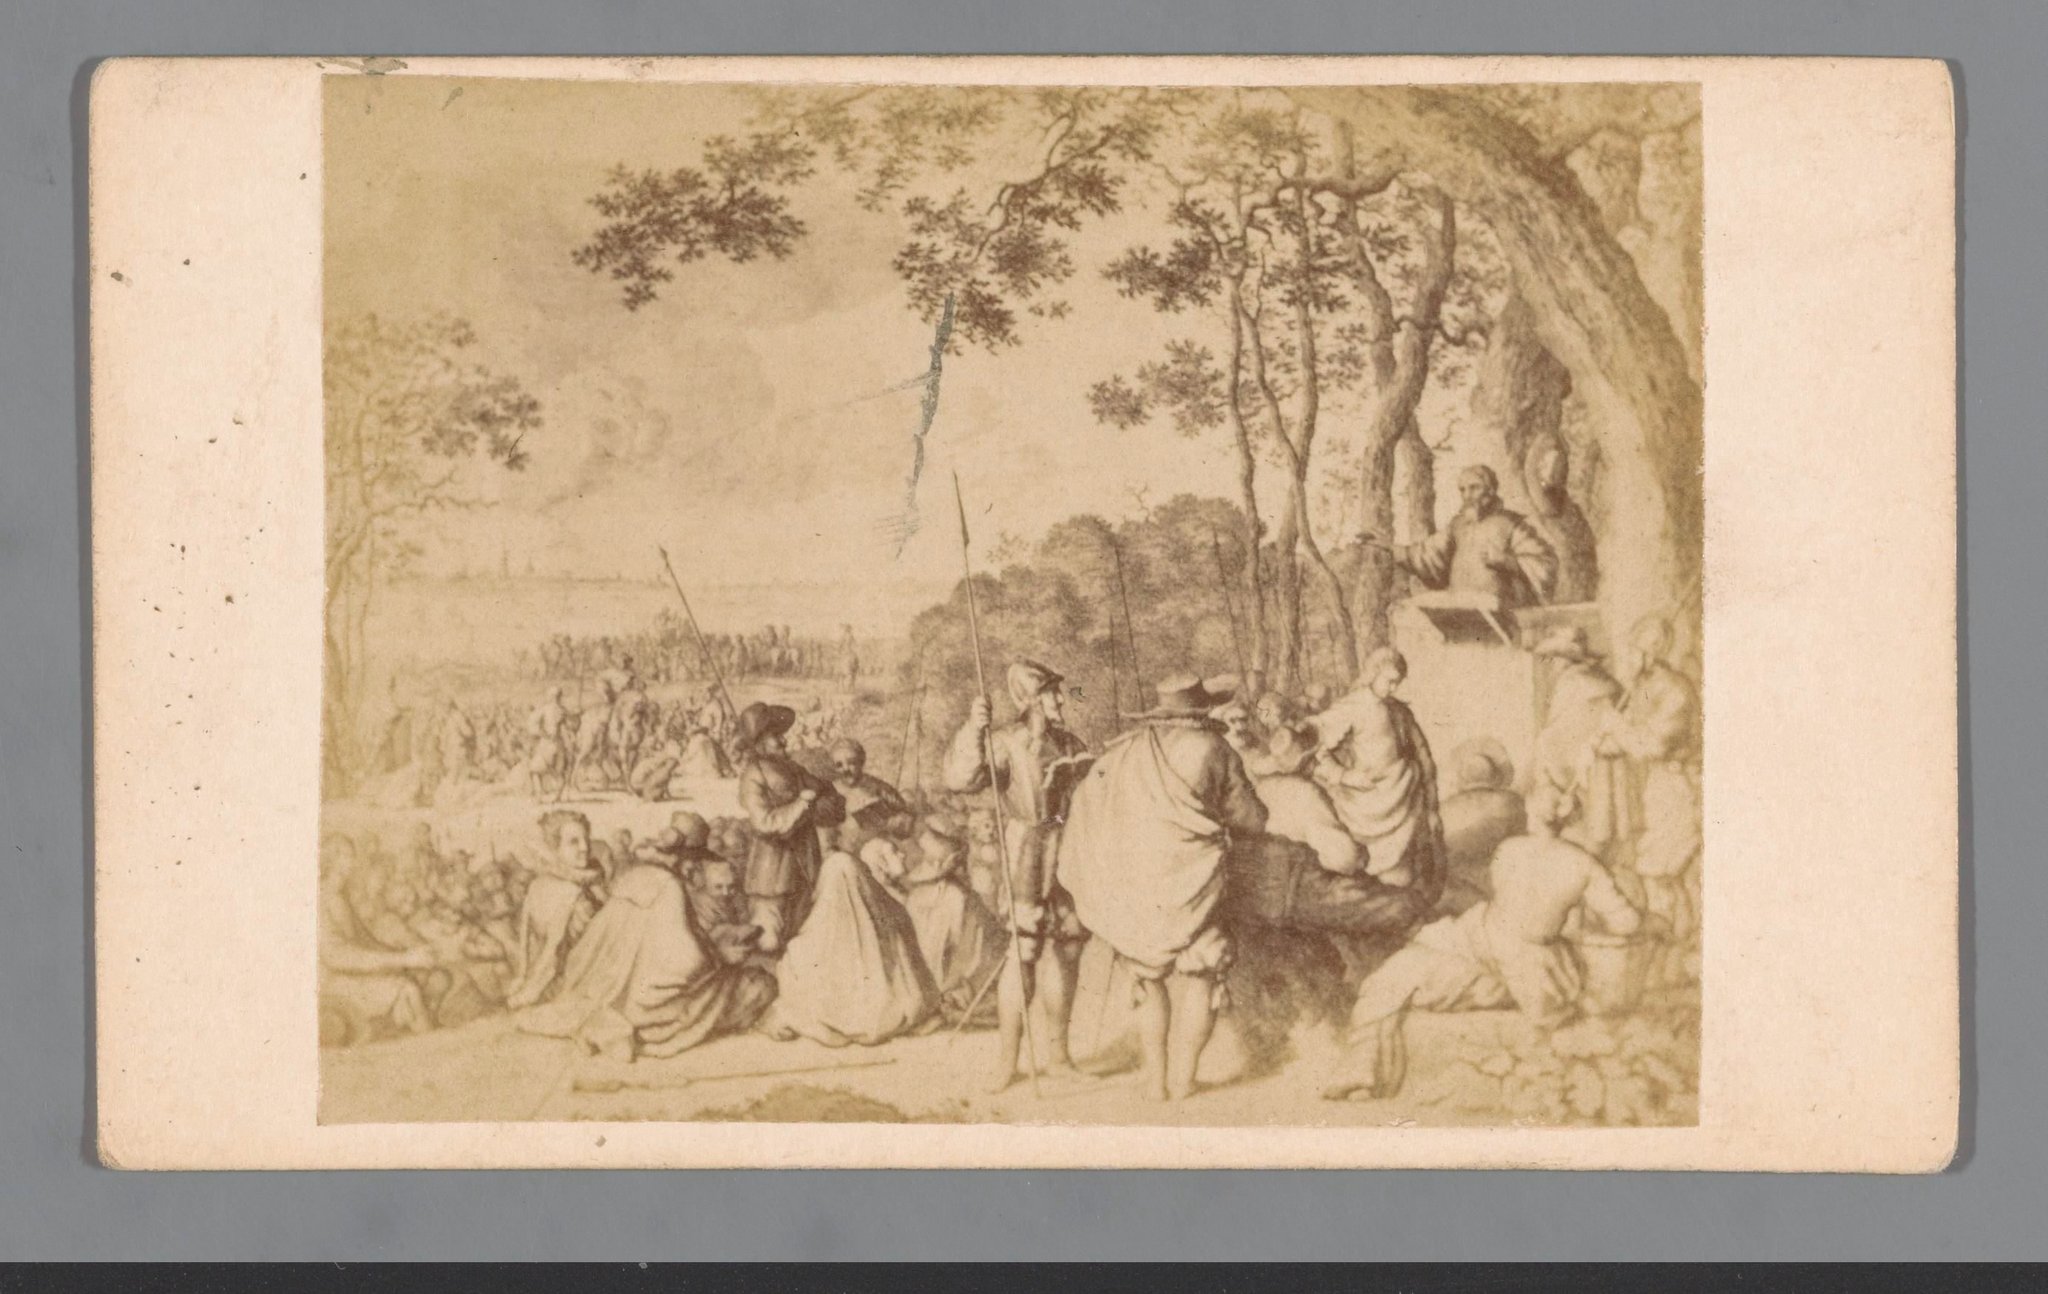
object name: photograph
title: Fotoreproductie van een gravure van gereformeerde prediking bij Antwerpen in 1566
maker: Anonymous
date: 1850-1900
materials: cardboard, photographic support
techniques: albumen print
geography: netherlands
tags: preaching (in general)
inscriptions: number: ‘4’, inscription: ‘Predikatien der (...) der gewetens-/vrijheid.’